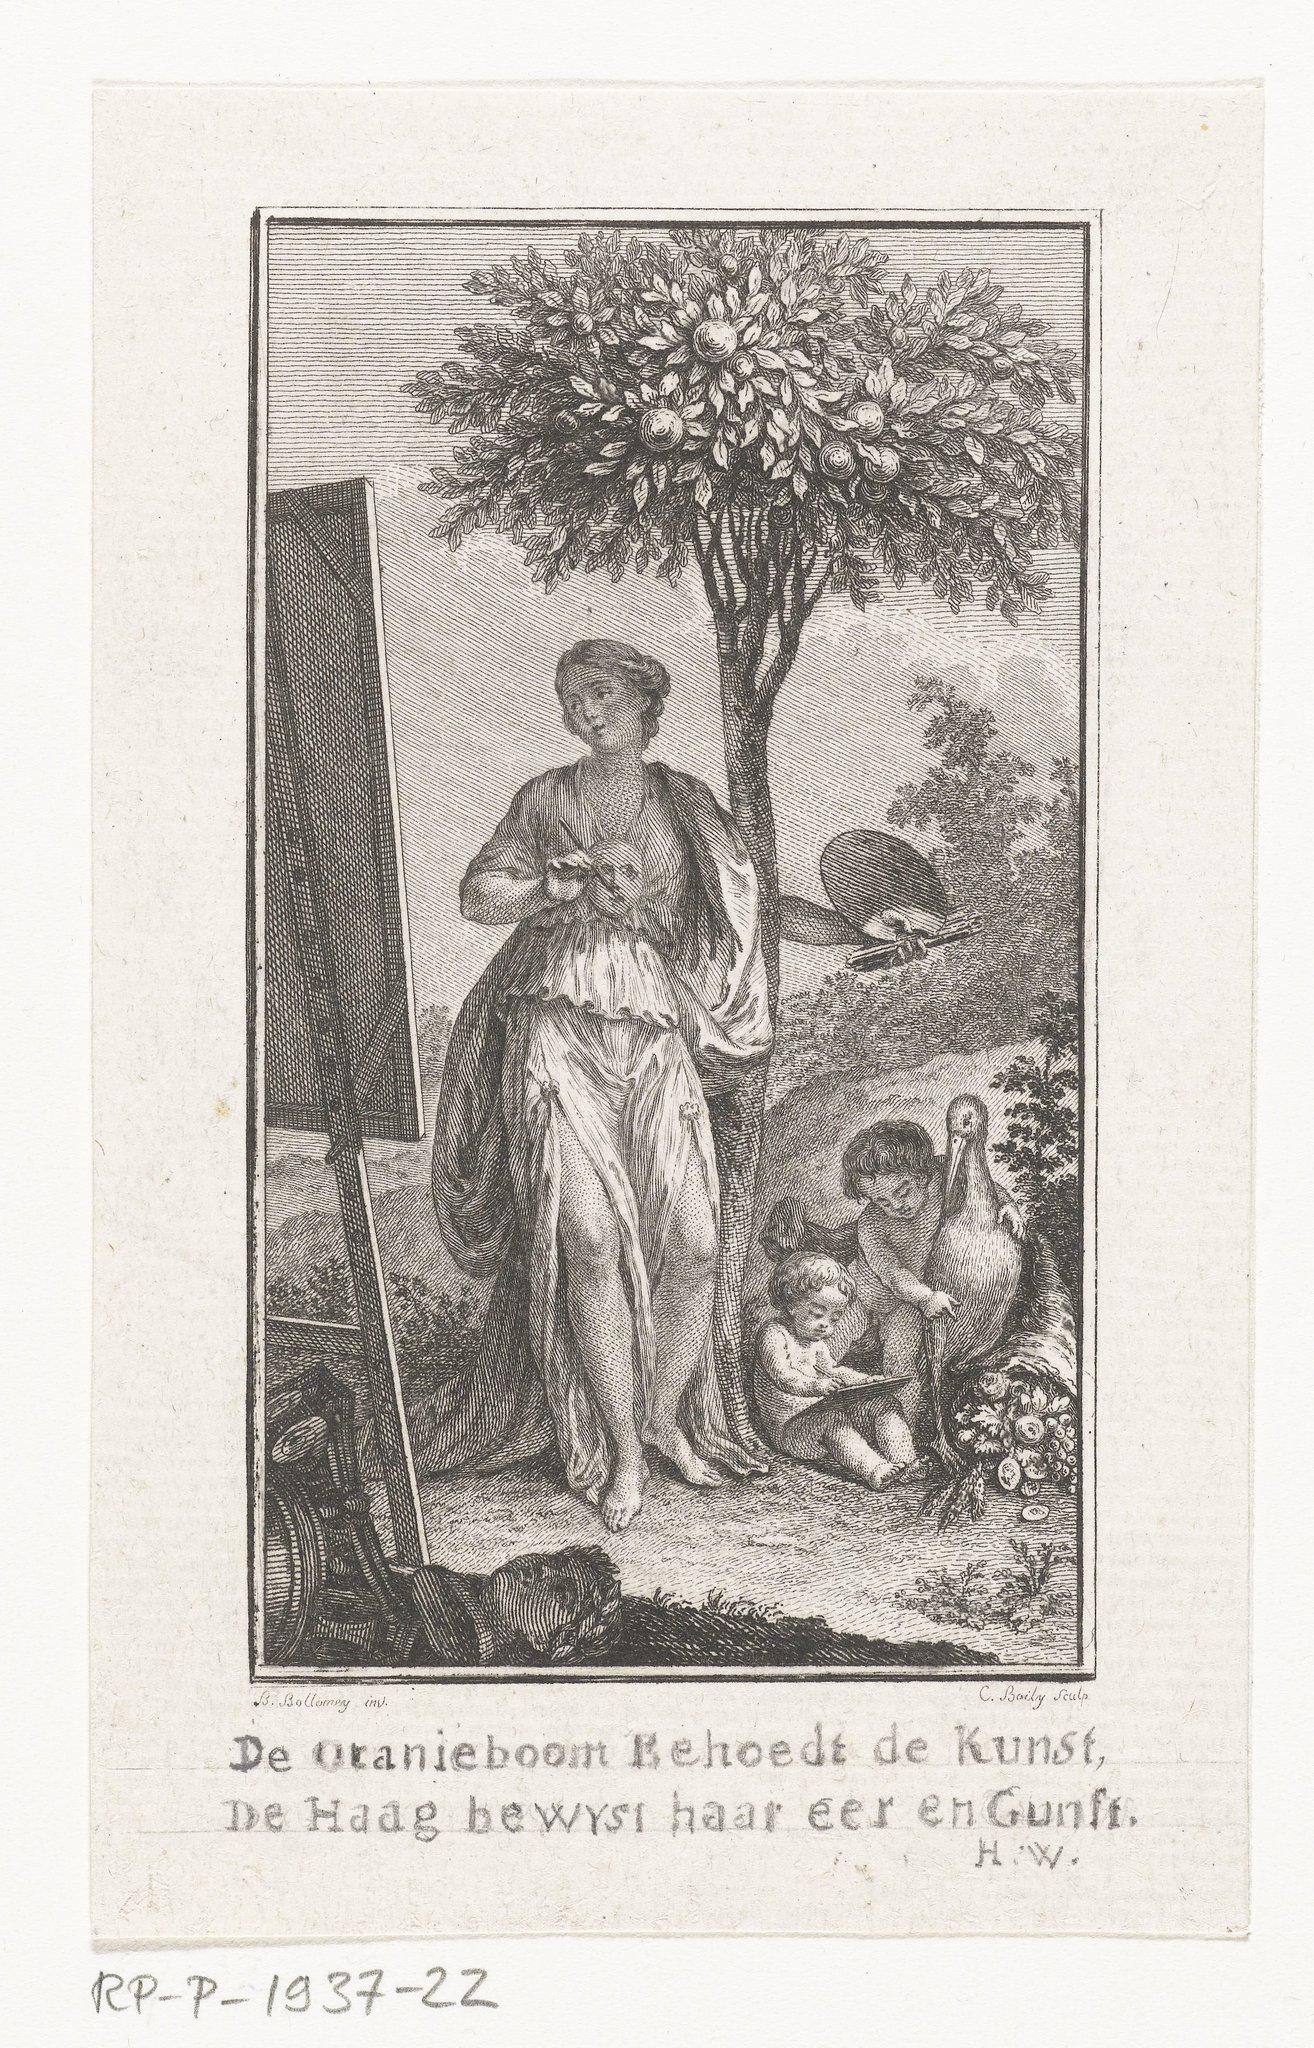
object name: print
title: De Oranjeboom behoedt de kunst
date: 1753-1813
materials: paper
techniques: etching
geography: netherlands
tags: person stimulating the arts; art lover, connoisseur, maecenas, patron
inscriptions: collector's mark: Lugt 2760, collector's mark: Lugt 2228, inscription: ‘De Oranieboom behoedt de kunst, de haag bewyst haar eer en Gunst. H.W.’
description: Een schilderes staat in de open lucht te schilderen achter een ezel. Ze vindt schaduw onder een sinasappelboom. Onder de voorstelling een vers over de 'oranjeboom' als beschermheer der kunsten.